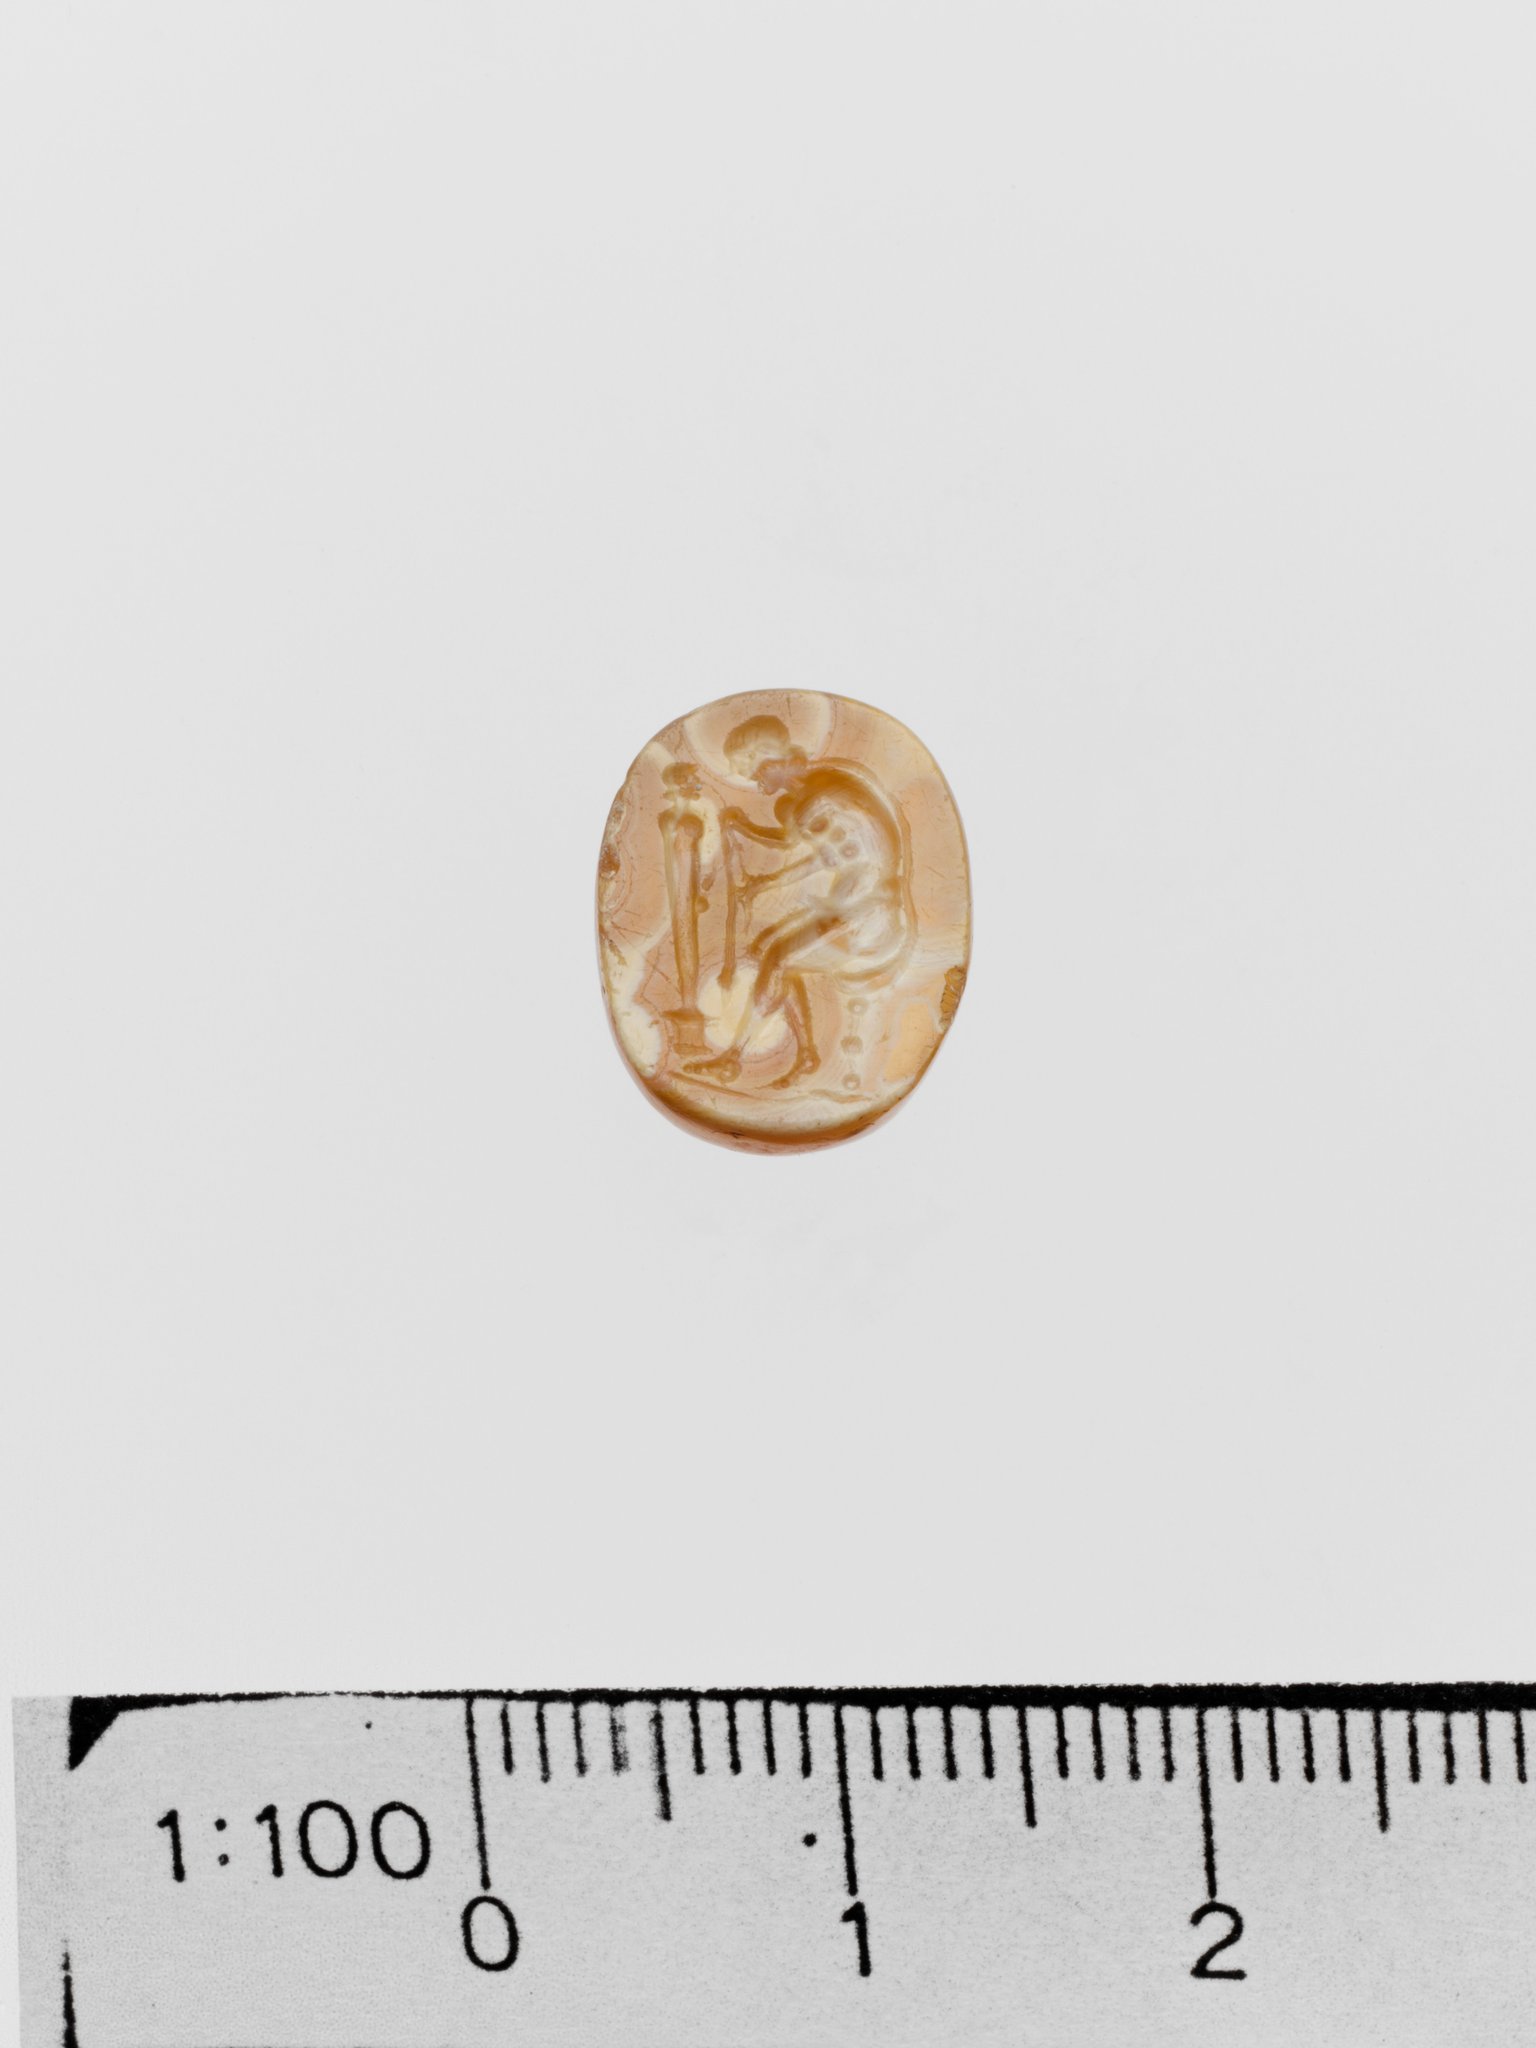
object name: intaglio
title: Agate ring stone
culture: italic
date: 300-101 BCE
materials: stone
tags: men,working